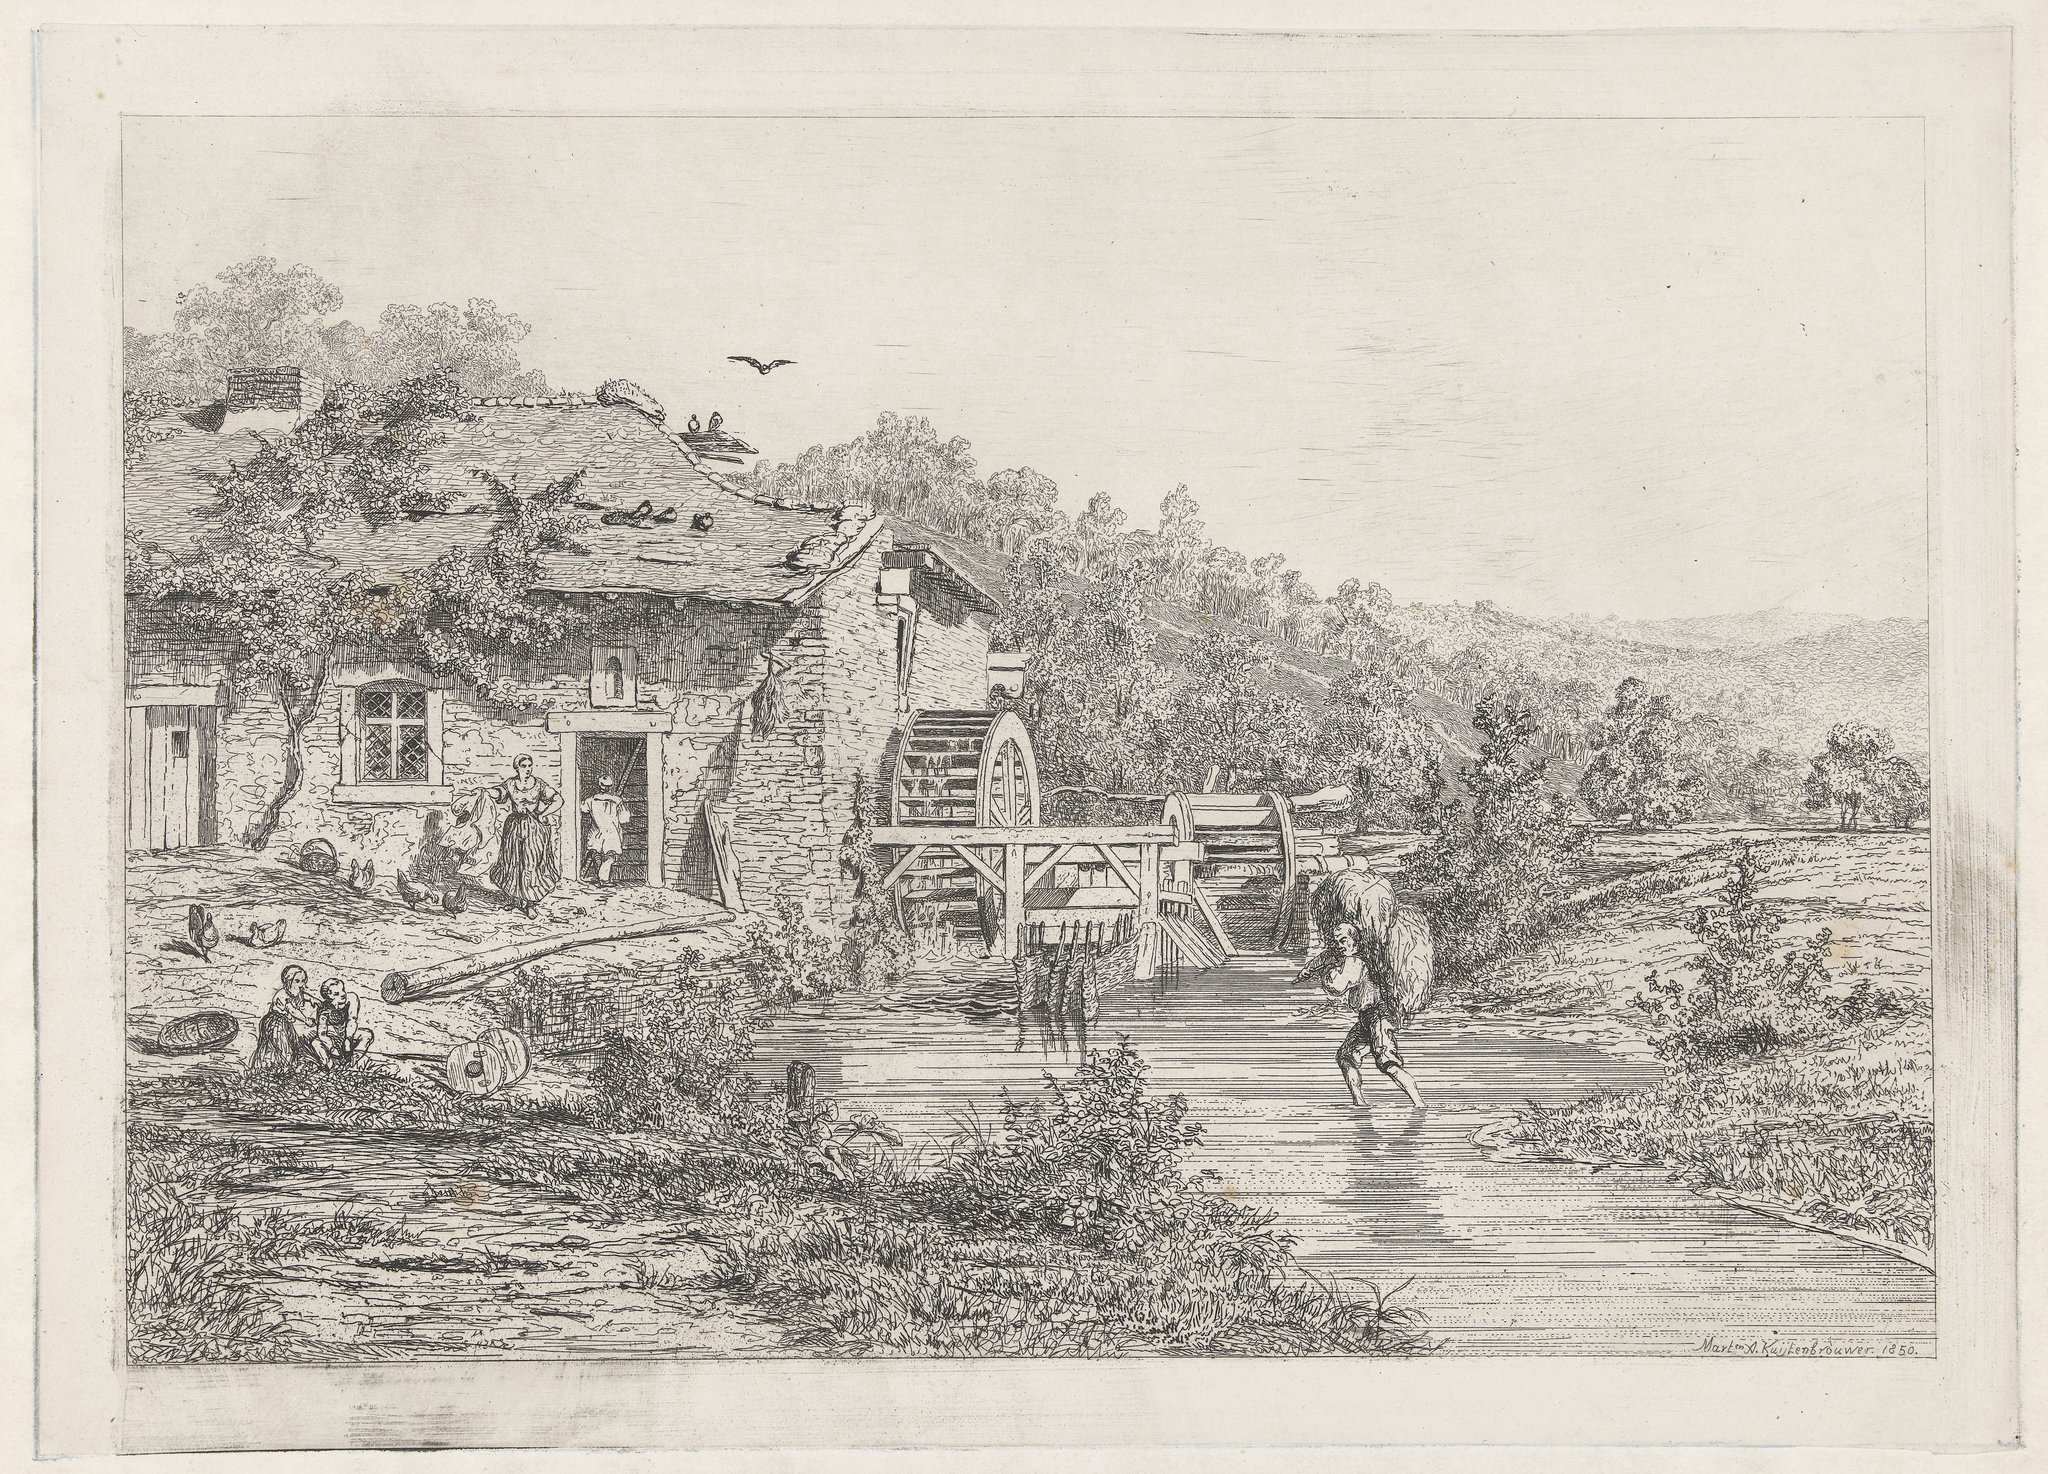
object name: print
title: Watermolen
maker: martinus antonius kuytenbrouwer jr.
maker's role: draughtsman, painter, print maker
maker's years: 1821-1897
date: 1850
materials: paper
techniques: etching, roulette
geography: brussels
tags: agricultural products and by-products: hay, farmers - aa - female farmer, farmer's wife, brook, fowl (cock, hen, chicken, etc.), watermill in landscape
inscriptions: collector's mark: Lugt 2228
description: Landschap met een watermolen aan een beek. In de beek loopt een man met een baal hooi op zijn rug. Op het erf voor de molen staat een boerin en lopen een paar kippen. Aan de waterkant twee spelende kinderen.